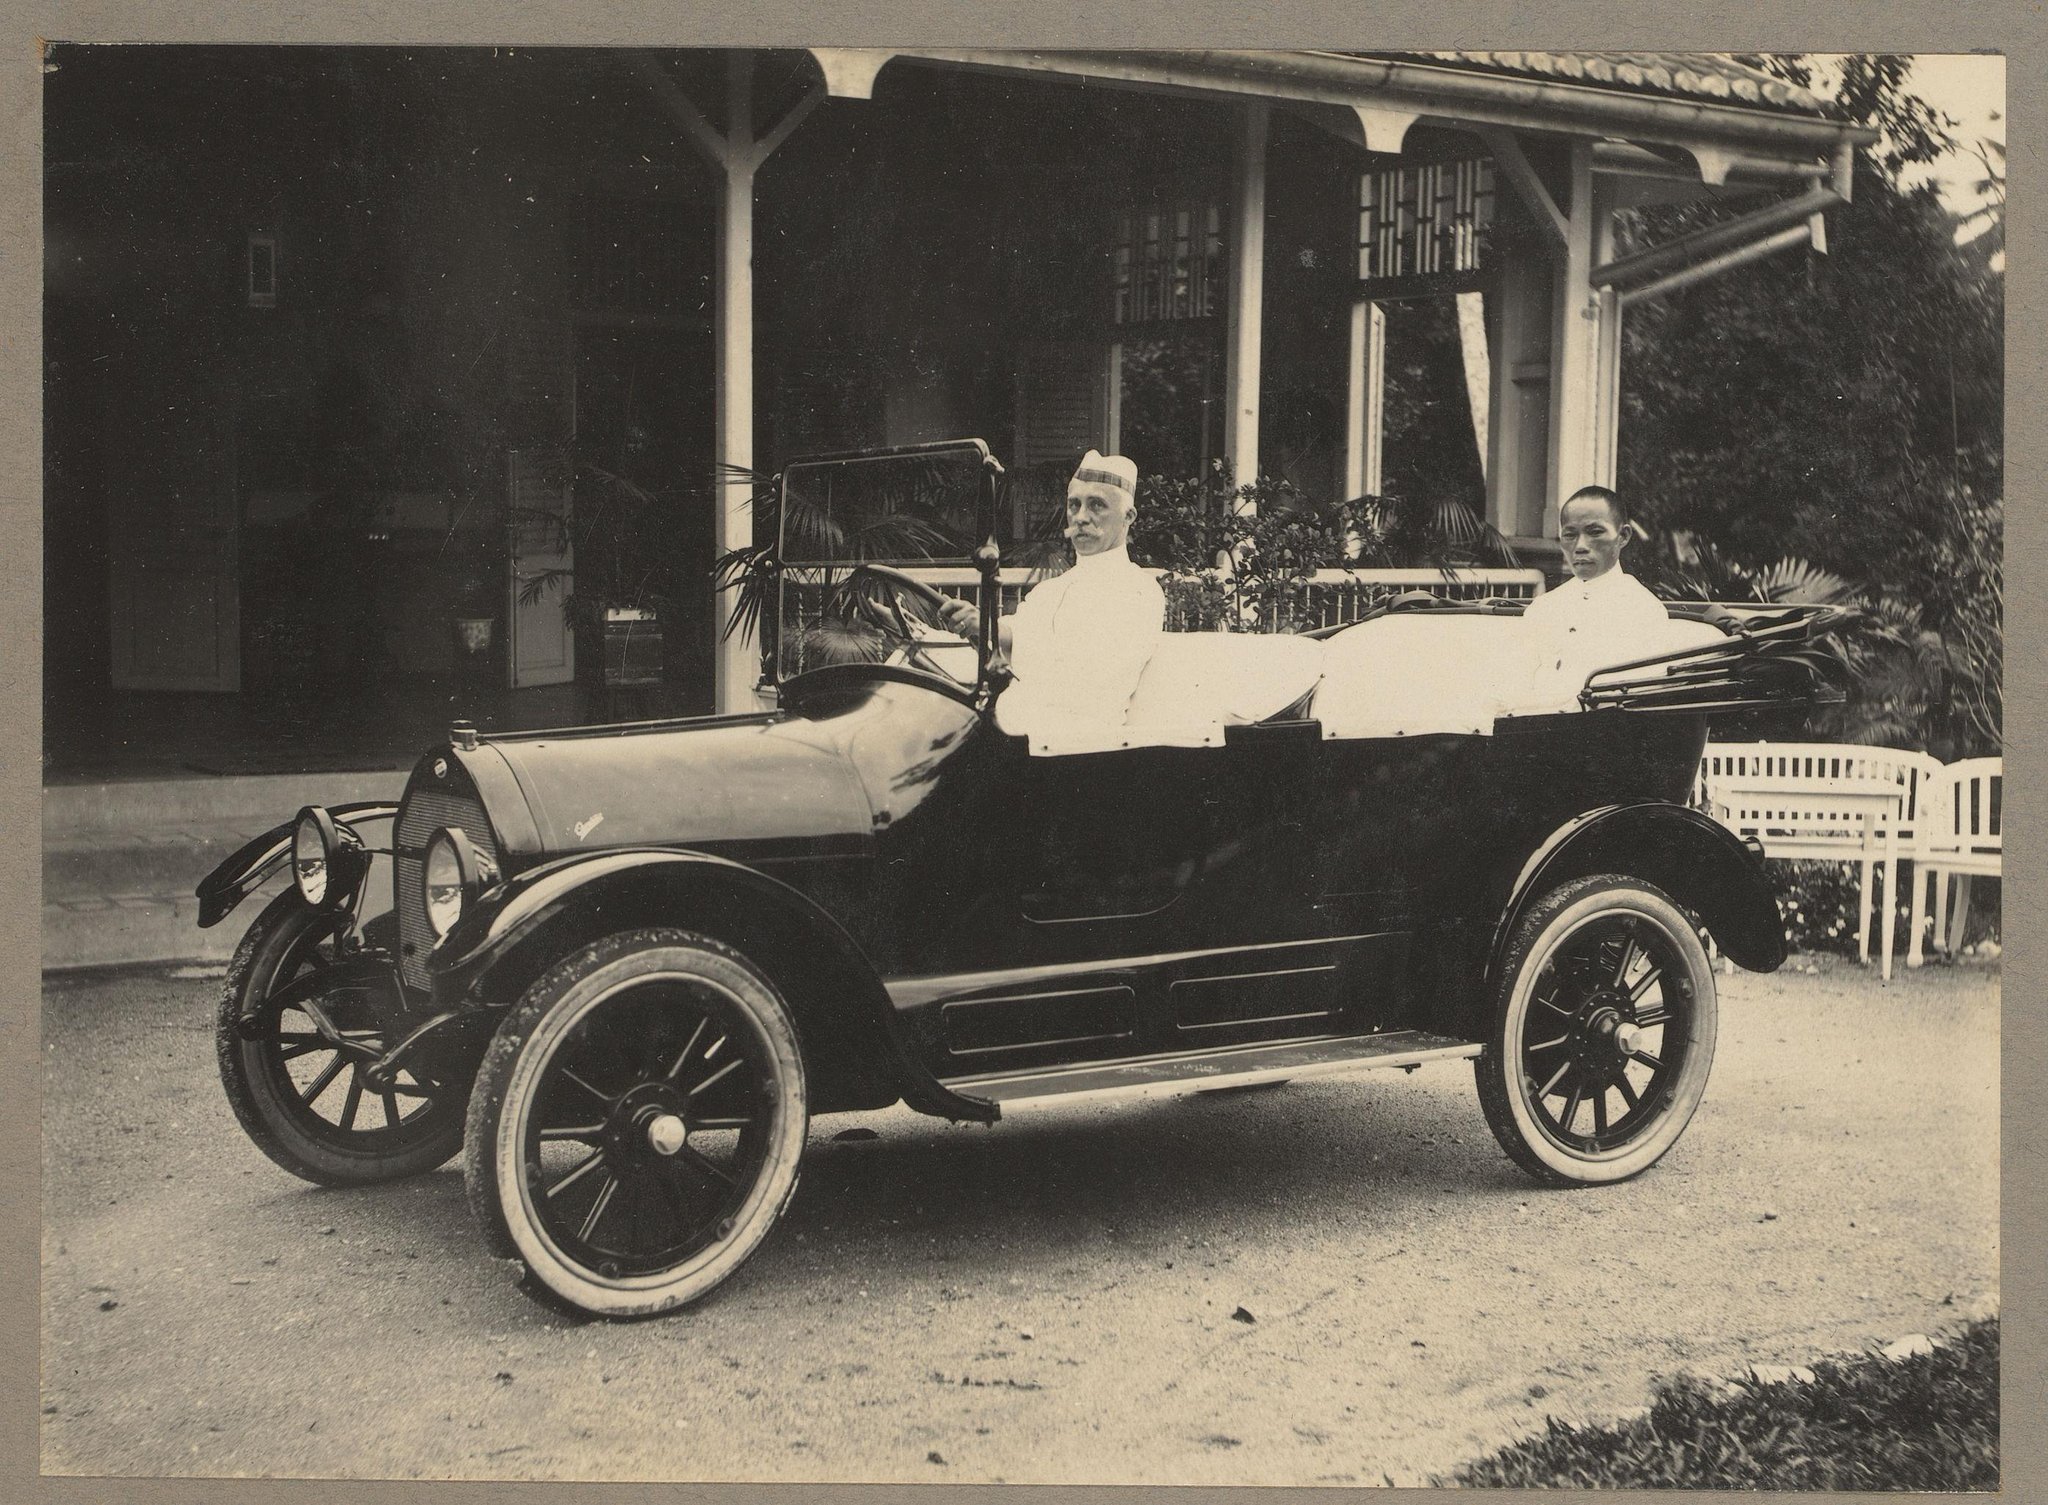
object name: photograph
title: Dienstauto Sectie-Chef Soengeiliat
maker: Anonymous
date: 1914-1919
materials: photographic support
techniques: gelatin silver print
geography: bangka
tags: robert julius boers, colonial system, mining, automobile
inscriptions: inscription: ‘Dienstauto Sectie-Chef Soengeiliat’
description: Dienstauto met chauffeur van de chef van de sectie Soengeiliat van de Banka-tinwinning. Onderdeel van het fotoalbum aangeboden aan Robert Julius Boers bij zijn vertrek naar Nederland in 1919 door het personeel van de Banka-tinwinning.